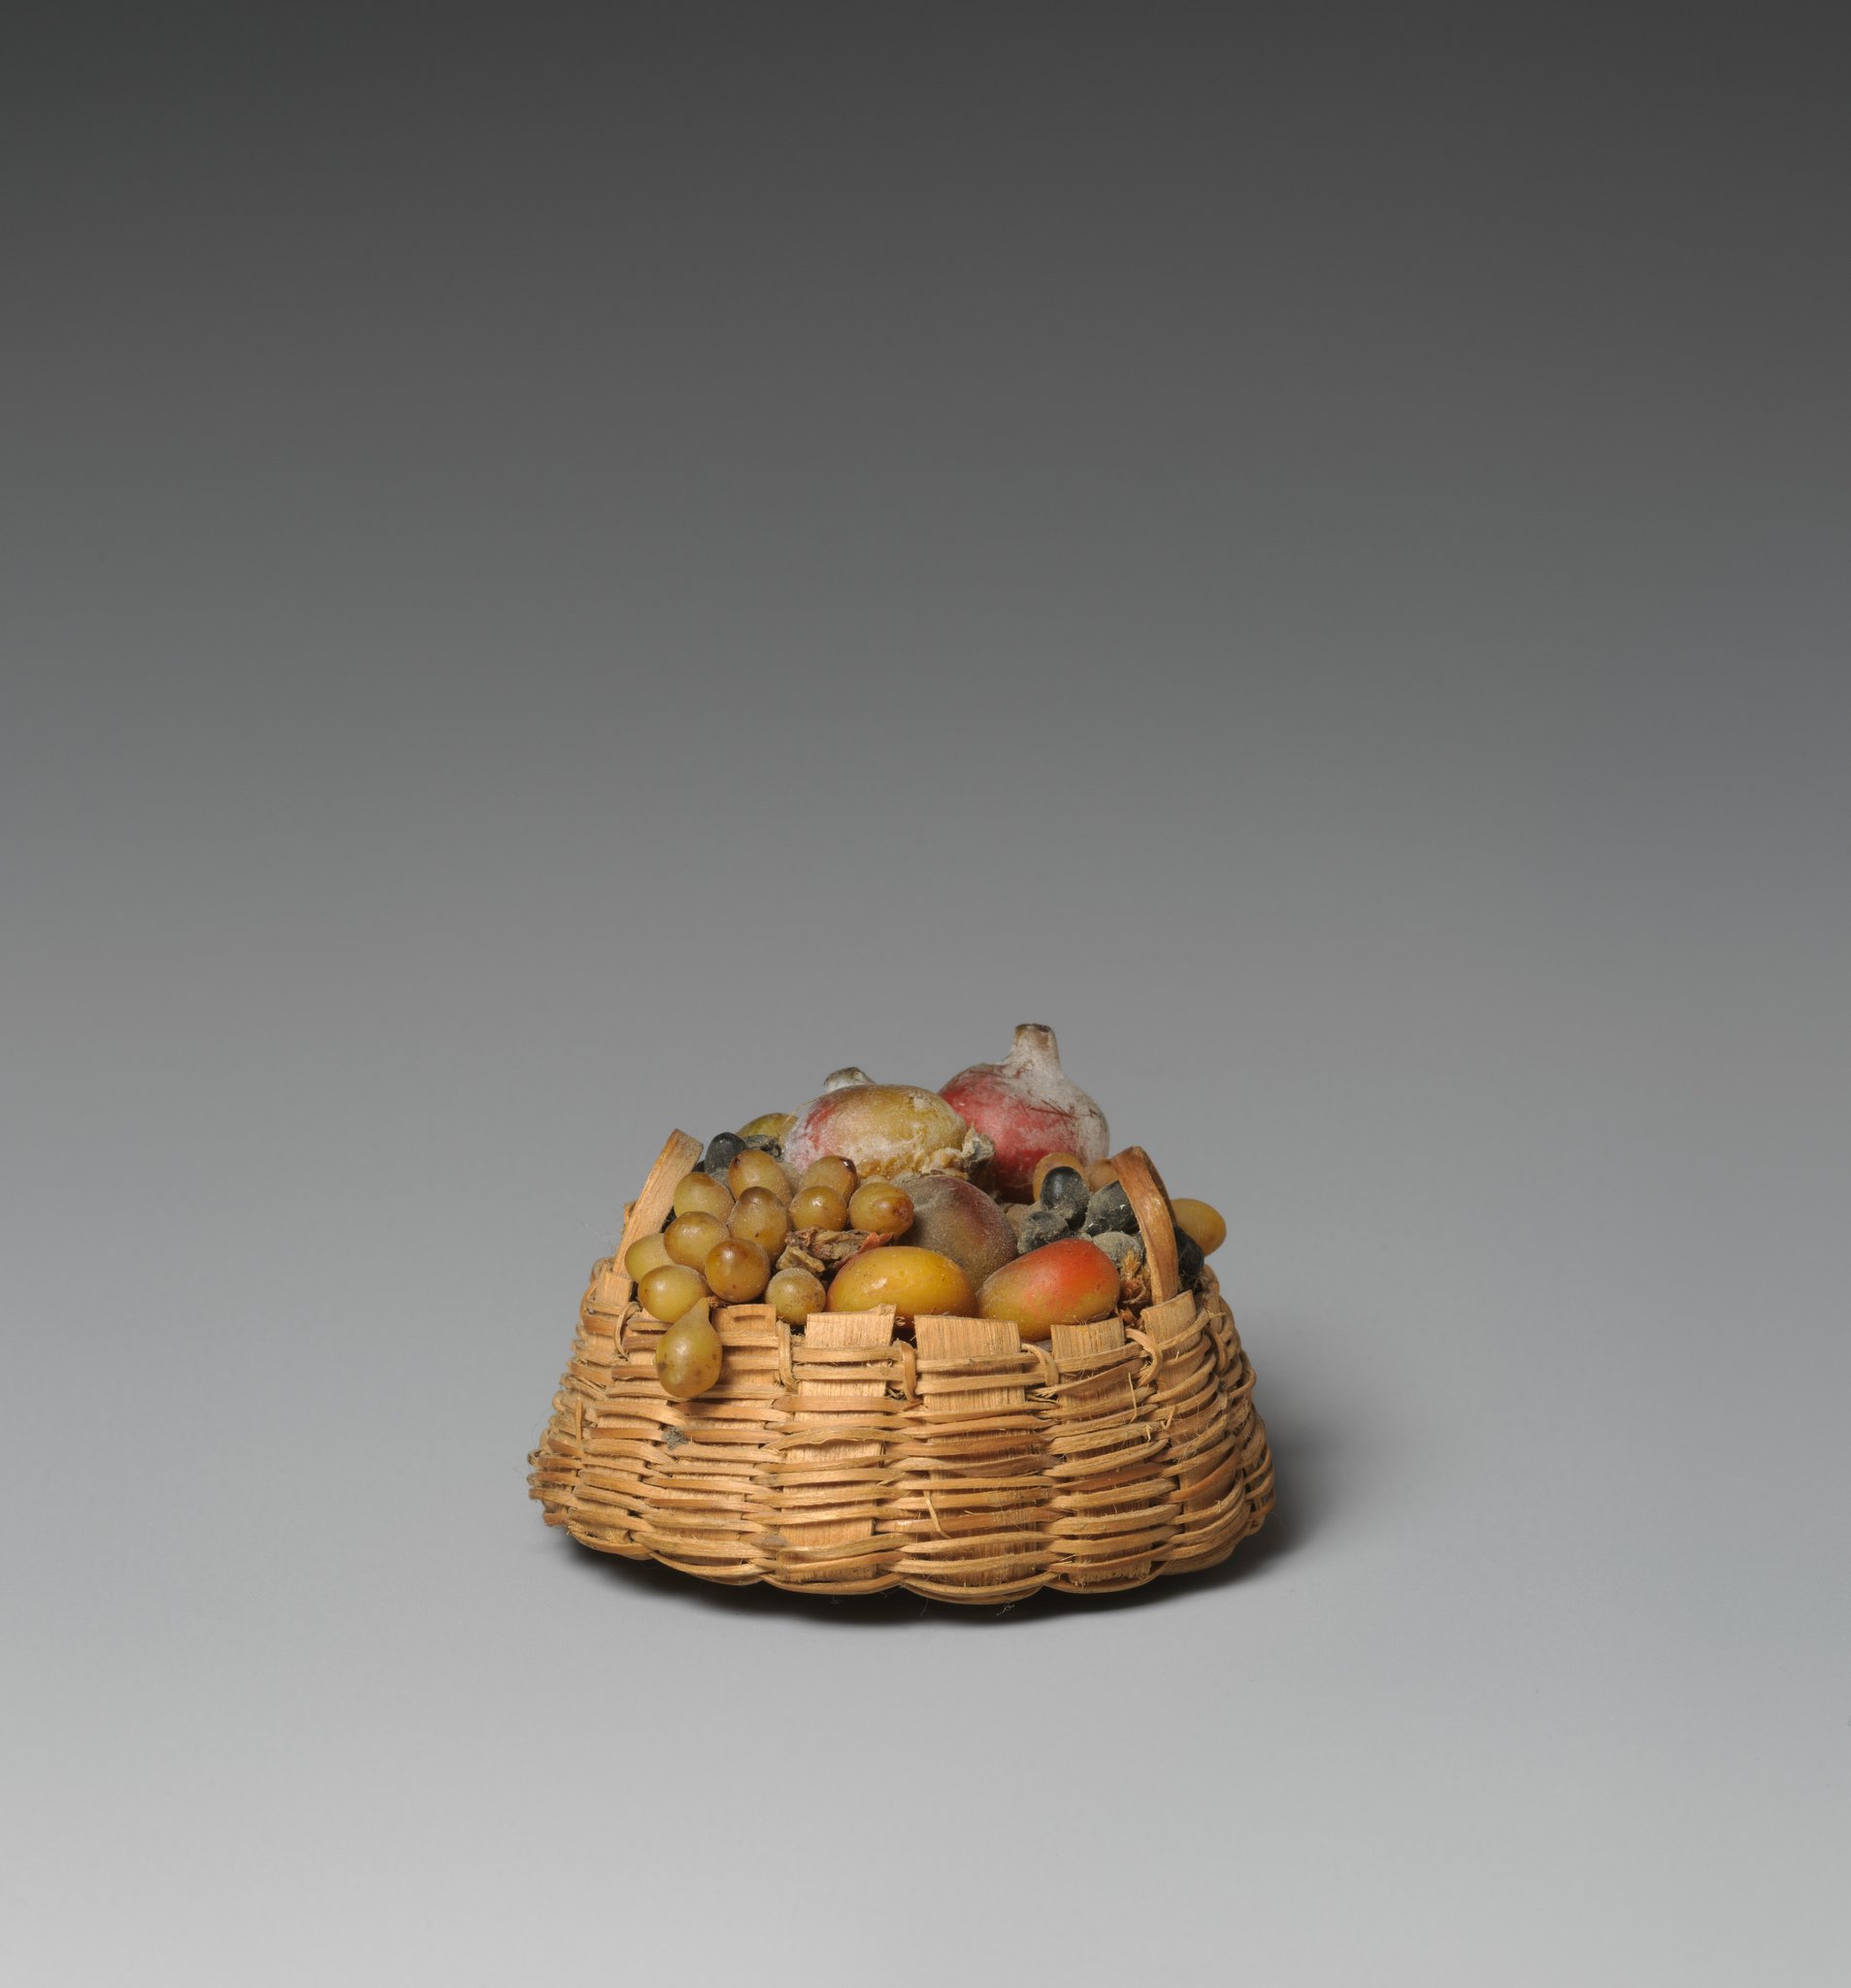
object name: crèche accessory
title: Round basket of fruit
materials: wax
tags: fruit